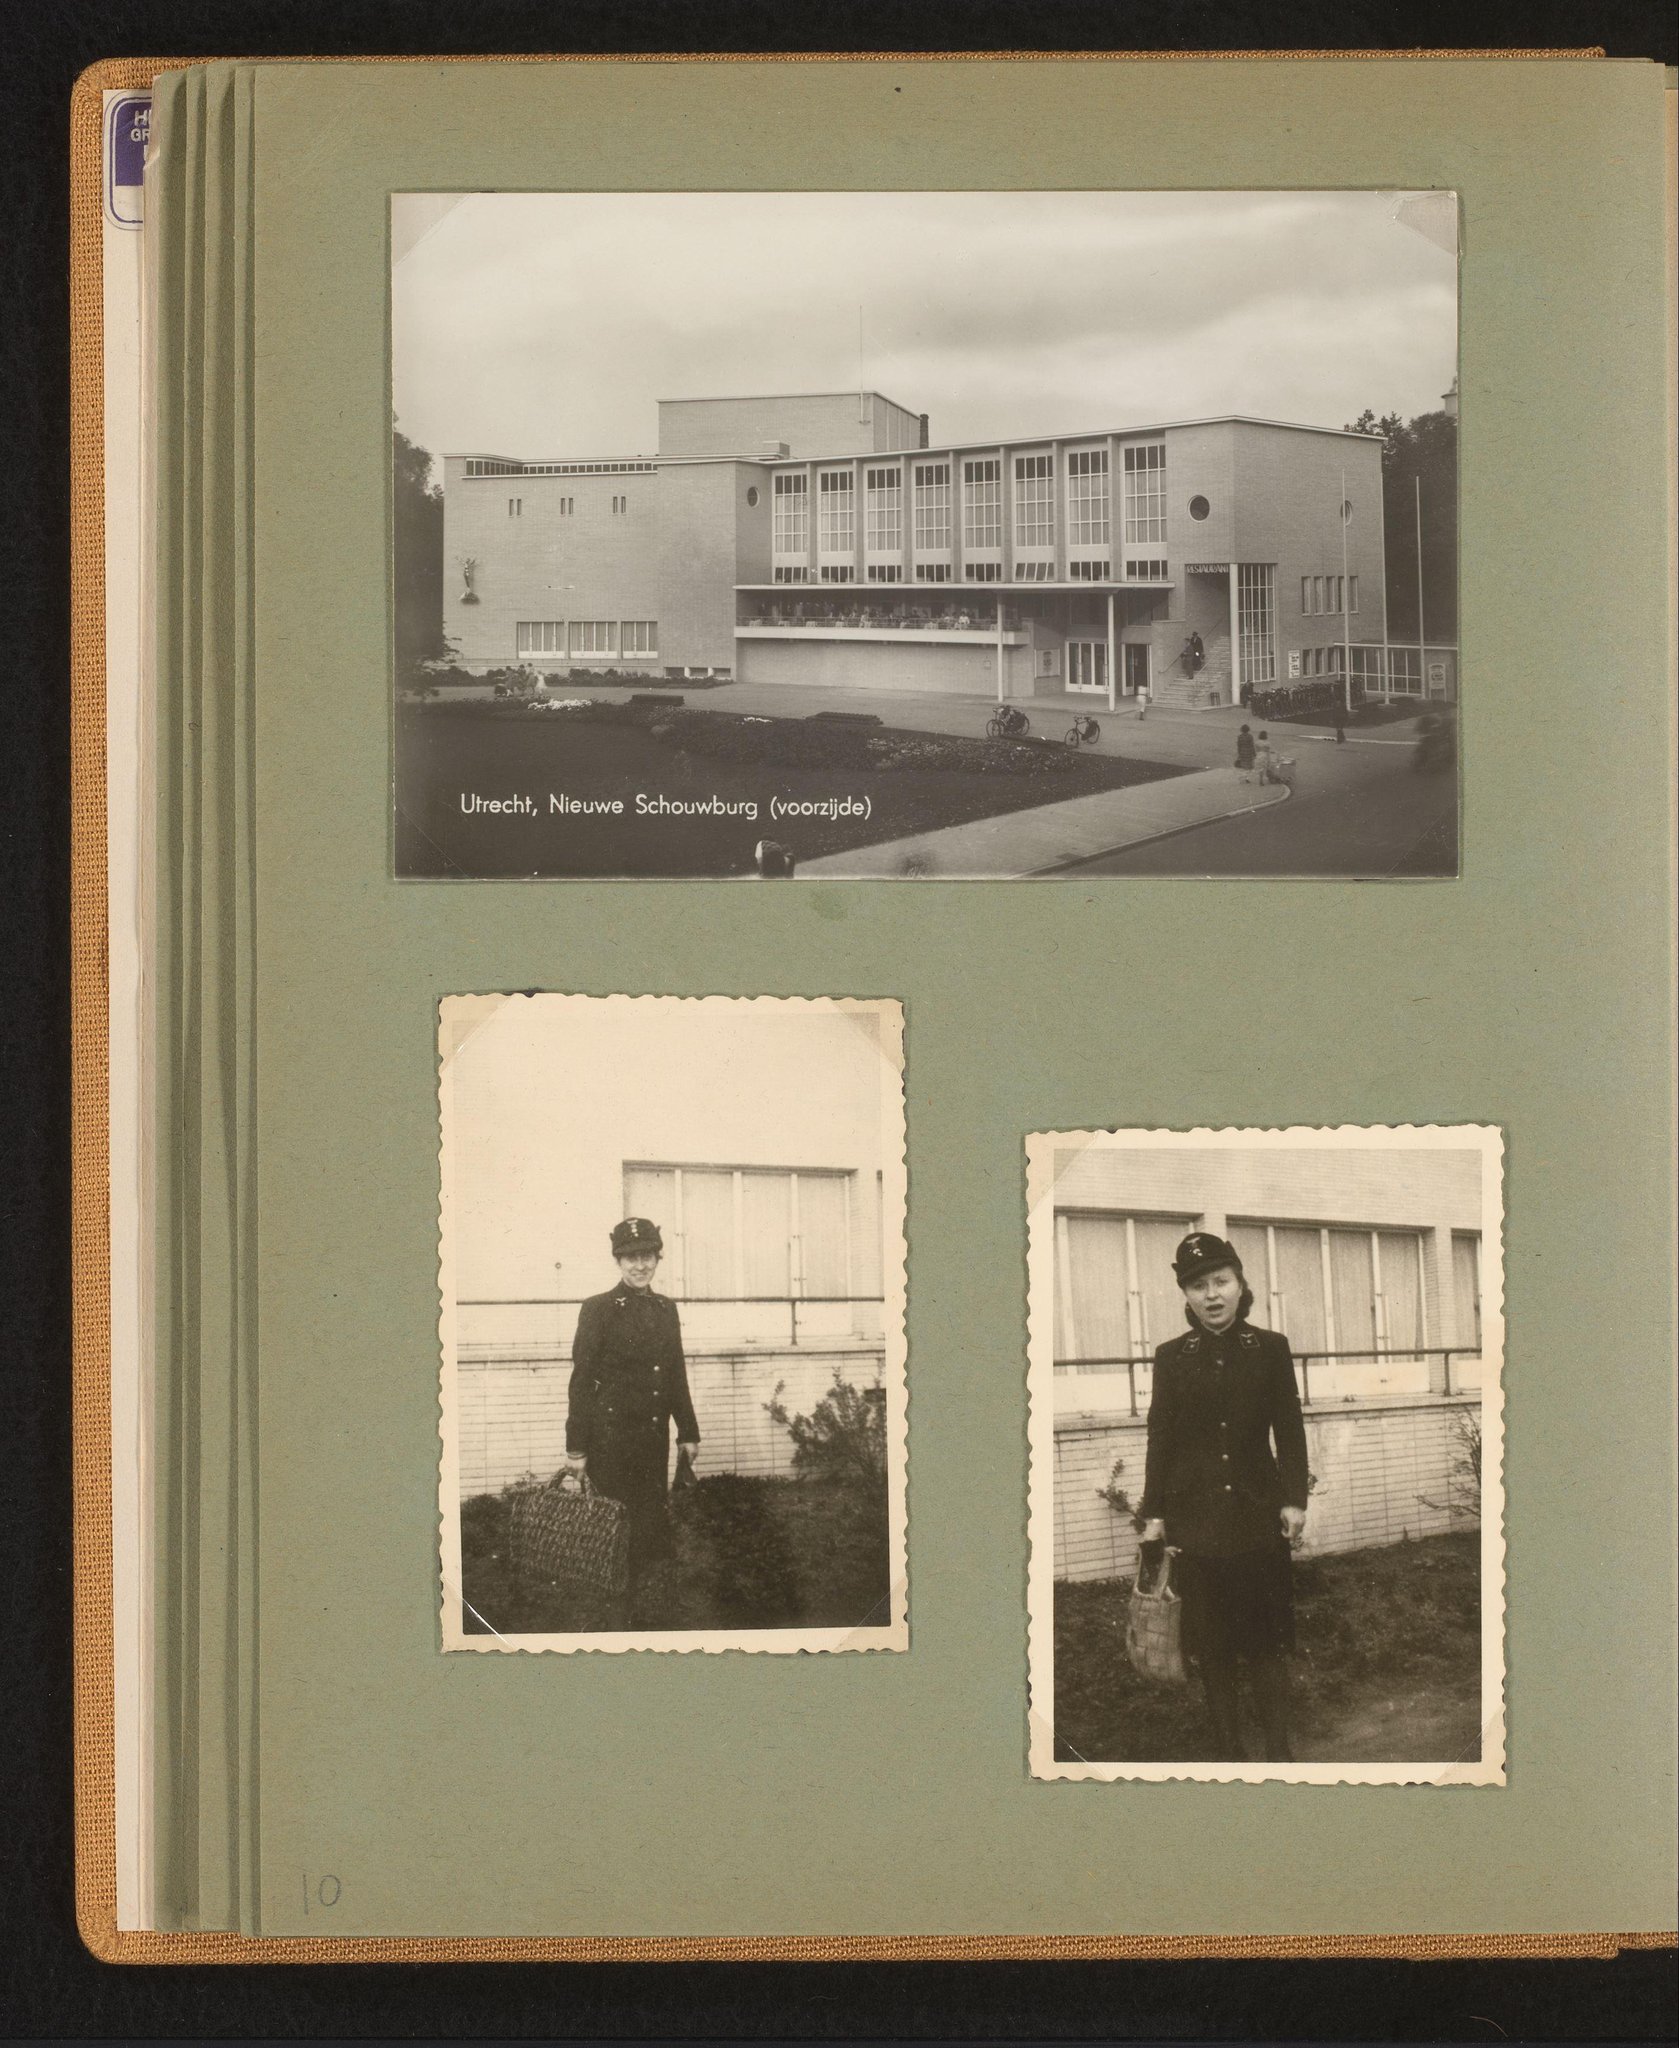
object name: photograph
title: Käte en Hedwig in uniform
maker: Anonymous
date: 1904-1944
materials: cardboard, photographic support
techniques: gelatin silver print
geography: utrecht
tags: railway-traffic, utrecht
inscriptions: inscription: ‘Käte Wohlfarth in April 1944 (Utrecht)’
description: Albumblad met een prentbriefkaart en twee foto's. Prentbriefkaart van de Nieuwe Schouwburg in Utrecht, het onderkomen tijdens de bezetting voor de Deutsche Reichsbahn. Twee foto's van twee vrouwen in uniform. Foto links is Käte Hohlfarth, rechts is Hedwig Schübert, samensteller van het album. Beide foto's te Utrecht in april 1944. Onderdeel van het fotoalbum Deutsche Reichsbahn, 1943-1944.